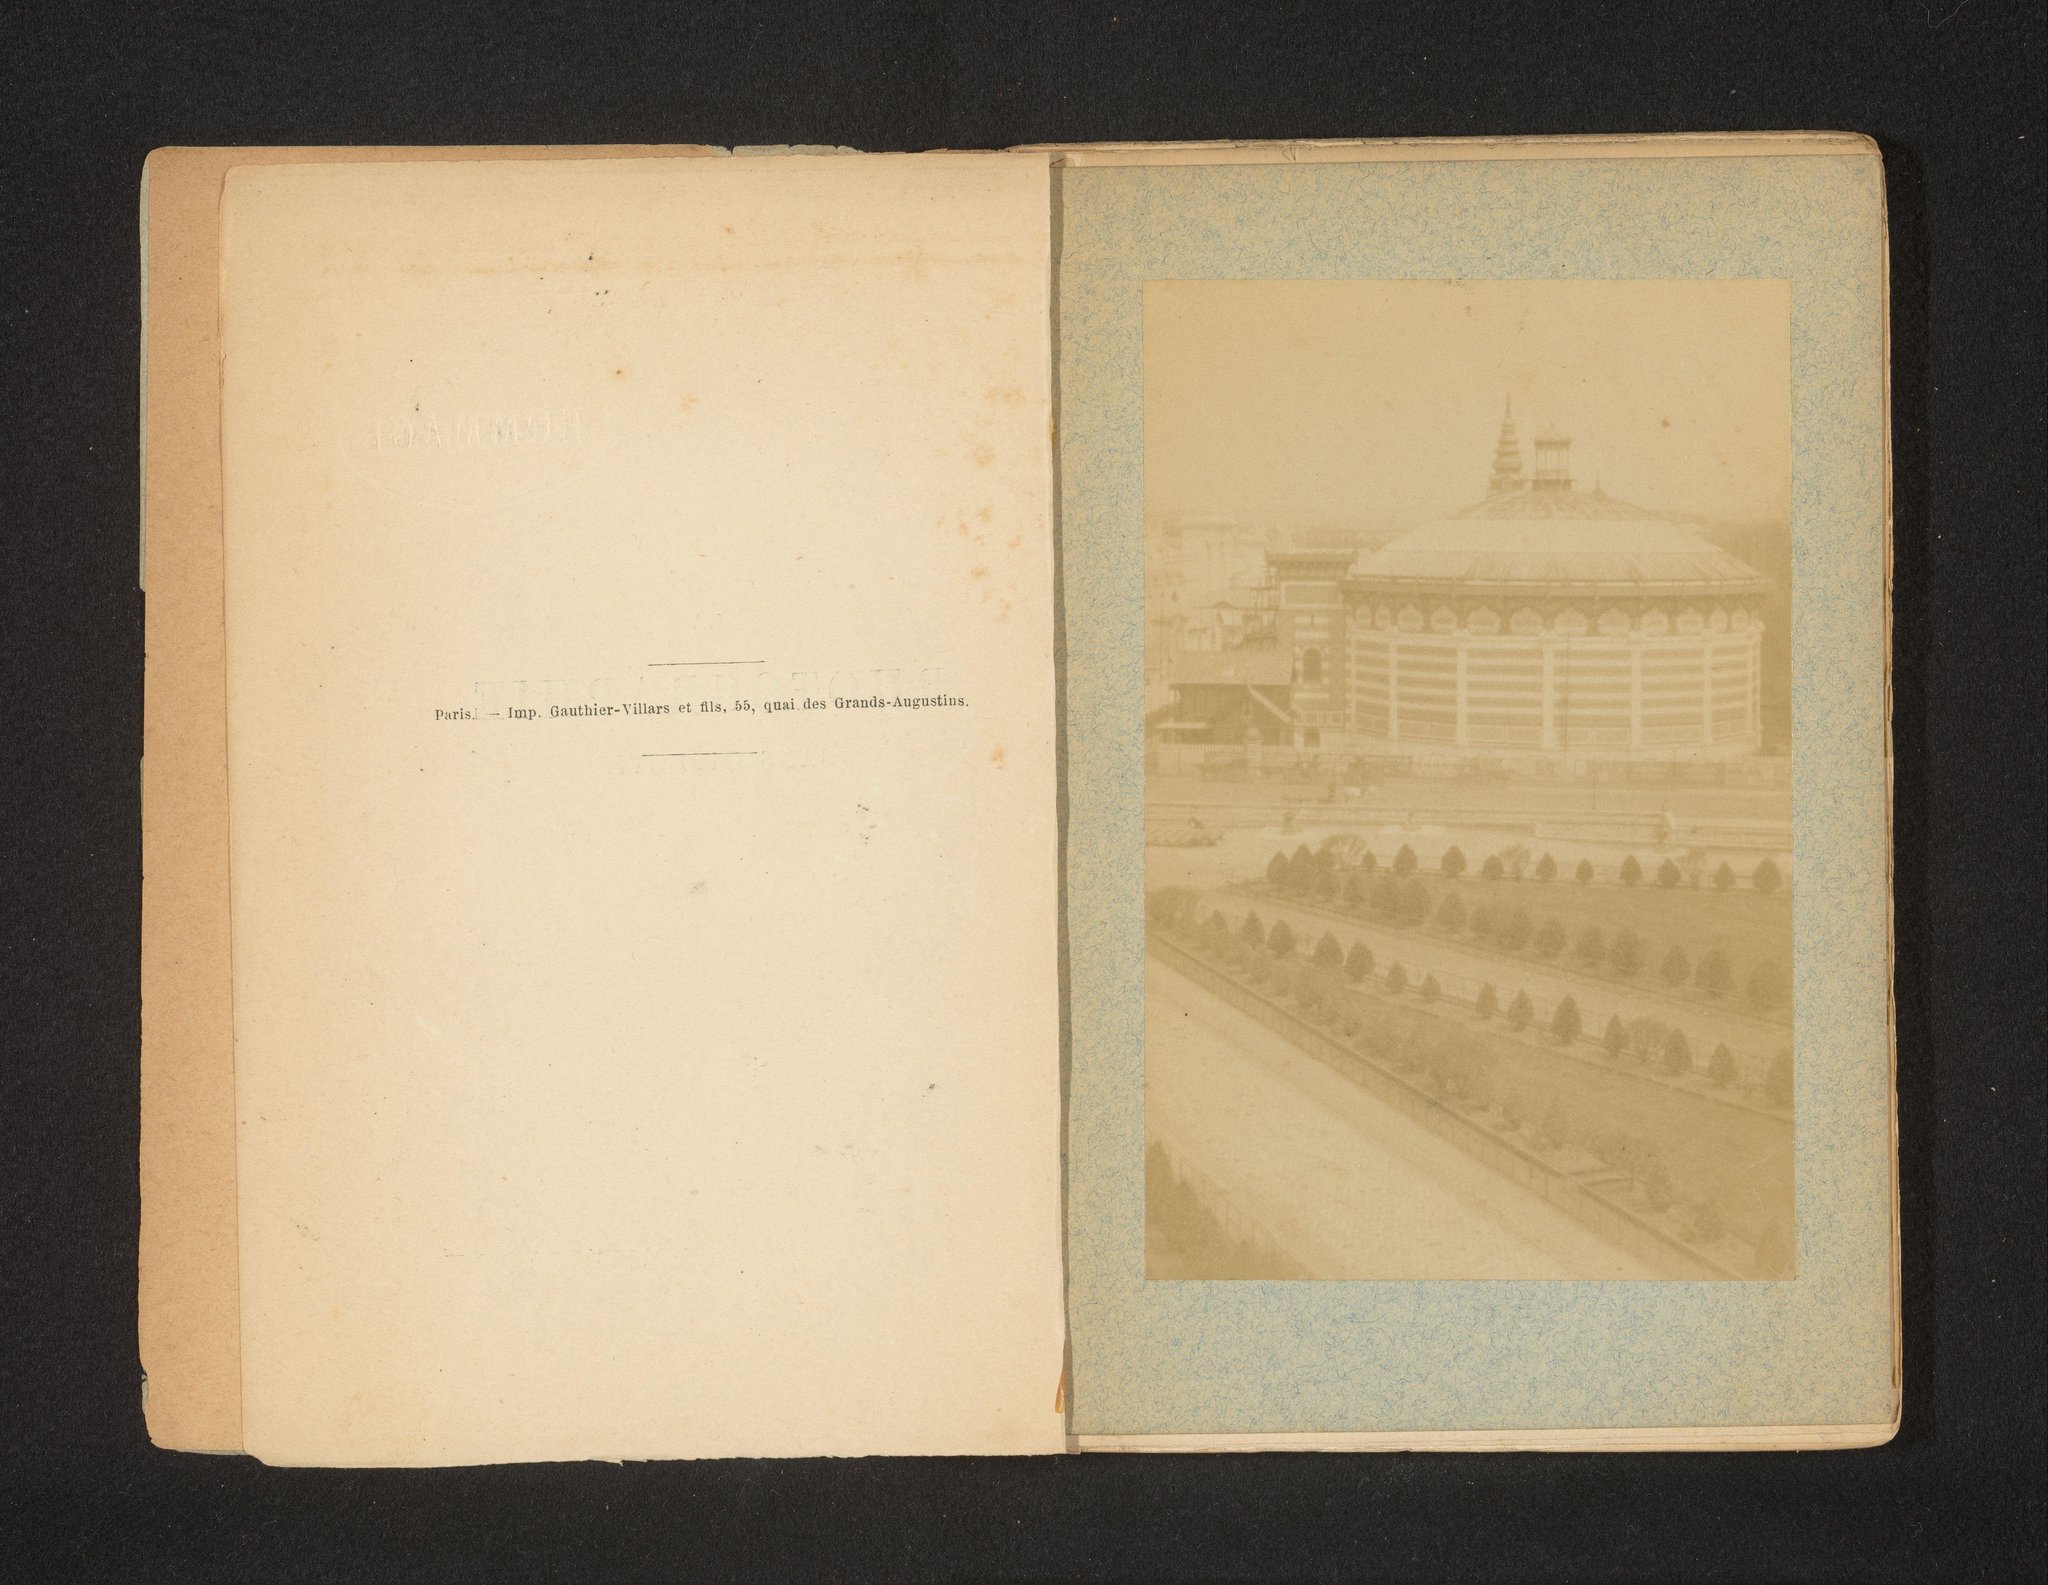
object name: photograph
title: Gezicht op de Esplenade des Invalides in Parijs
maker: Anonymous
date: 1886-1891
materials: photographic support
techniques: albumen print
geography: paris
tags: avenue, boulevard, promenade, esplanade, paris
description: Foto op tweede ongenummerde pagina voor titelpagina.